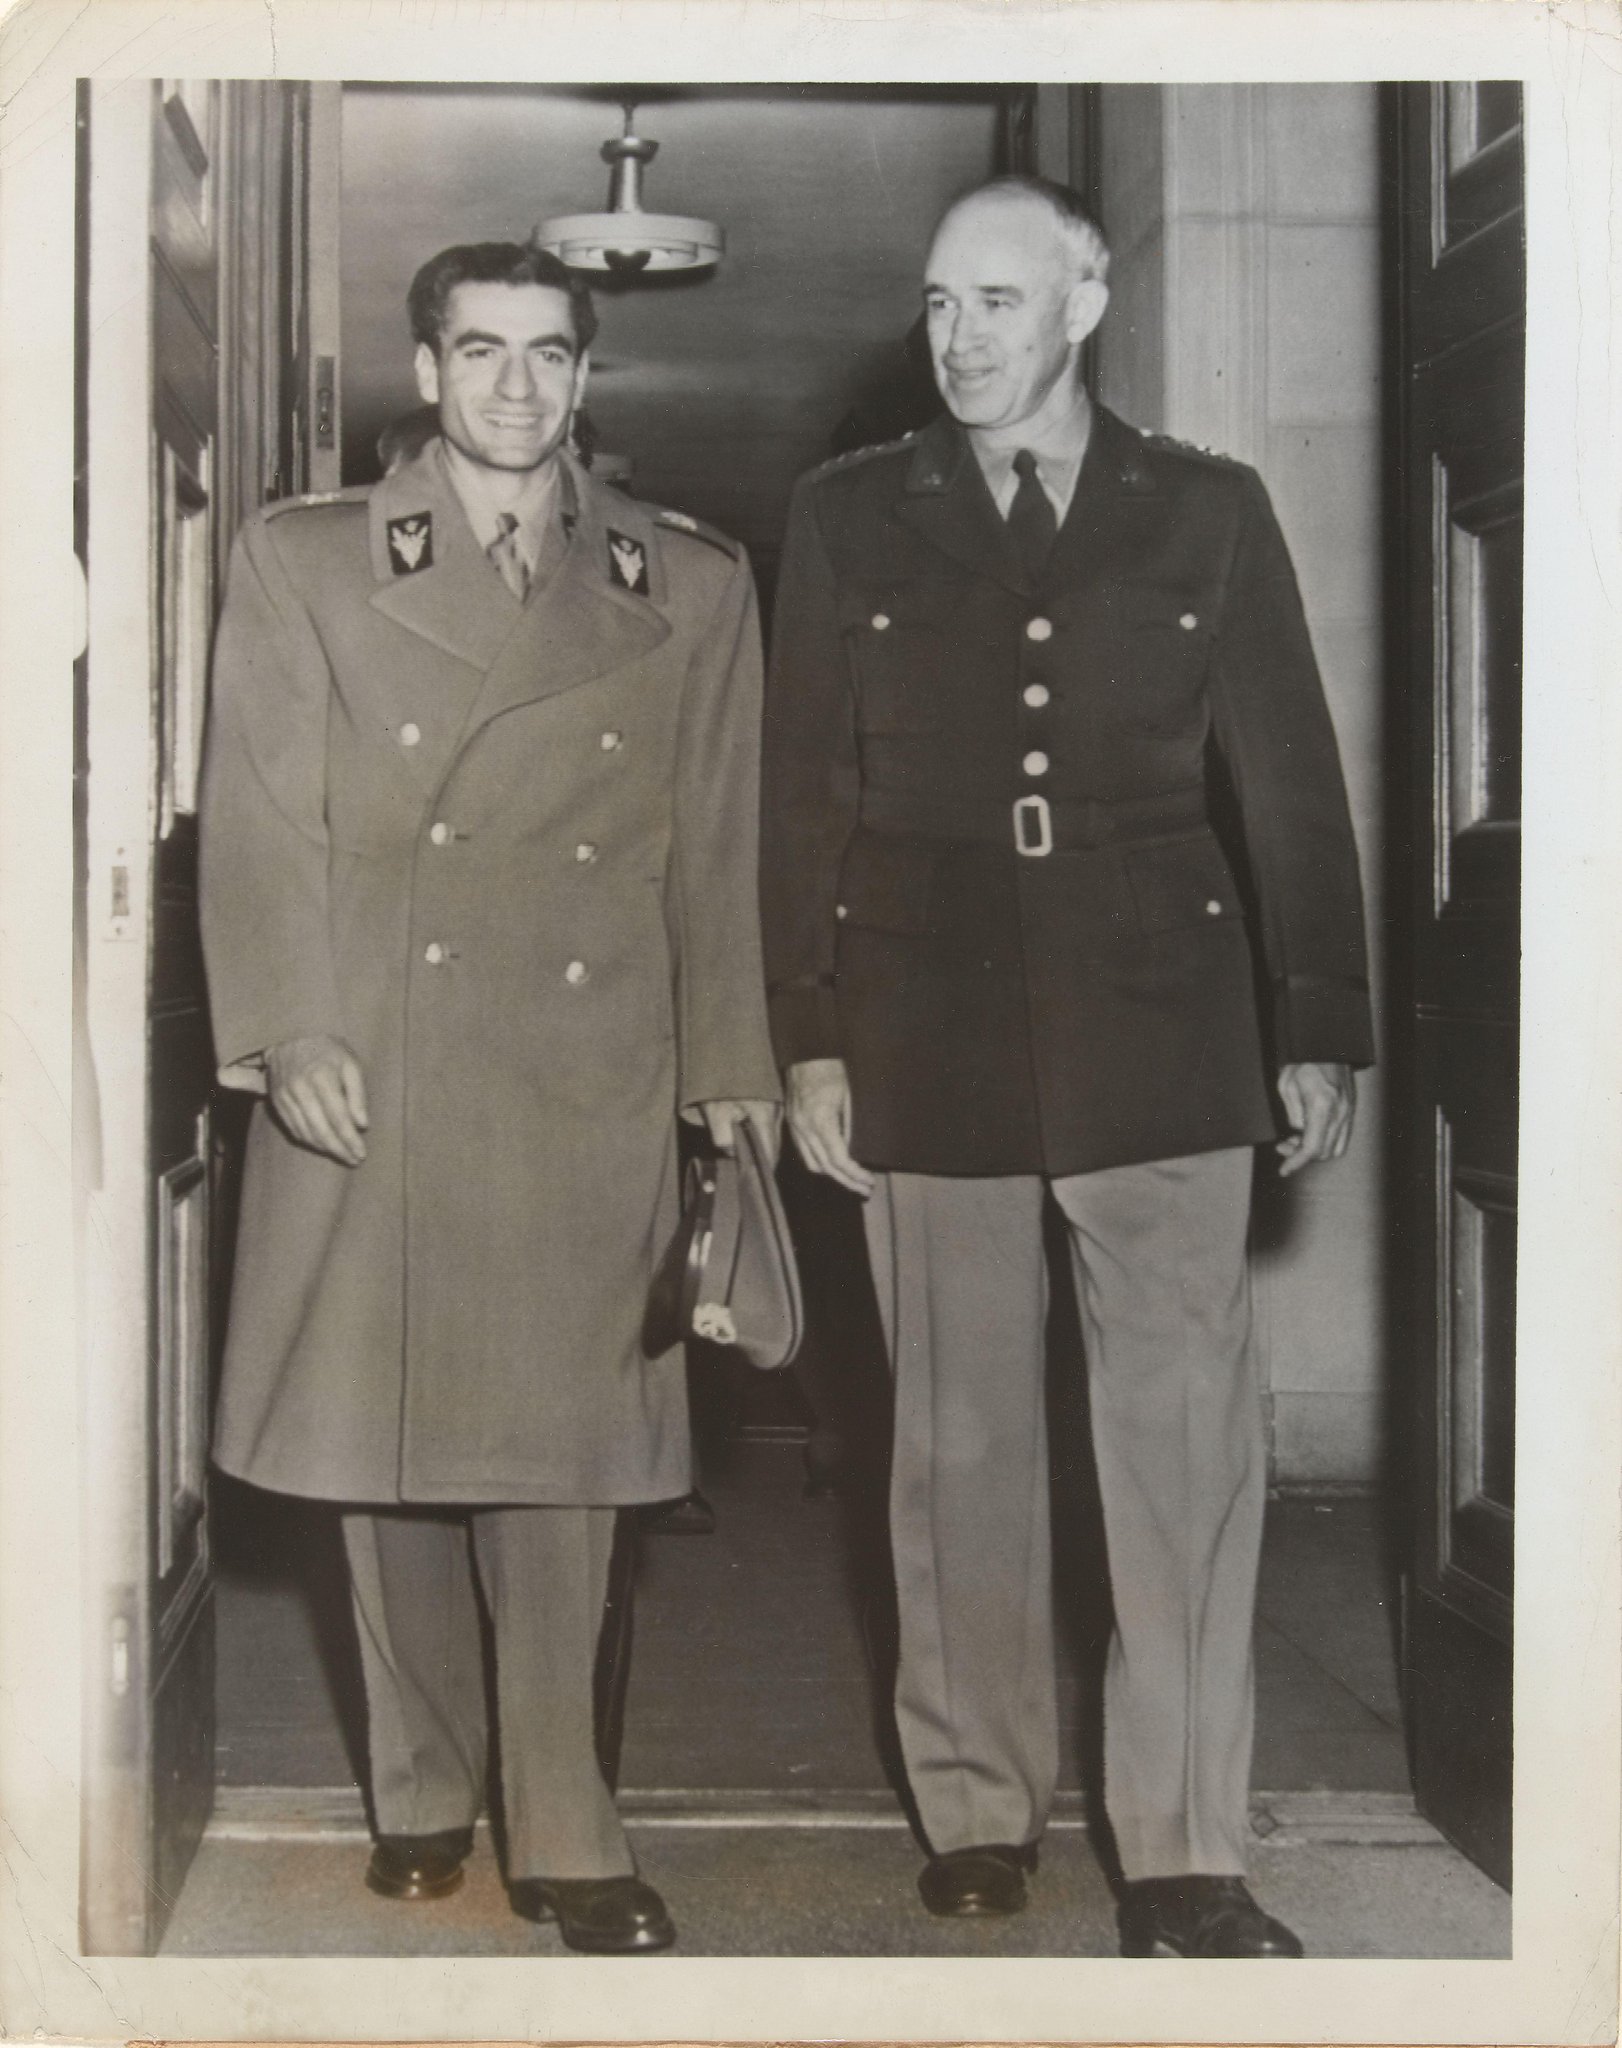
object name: photograph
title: Visiting potentate calls at the pentagon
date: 1949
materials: photographic support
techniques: gelatin silver print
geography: new york city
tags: new york (city)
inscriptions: stamp: ‘International new photos’, stamp: ‘pcopyright photo press belgium’